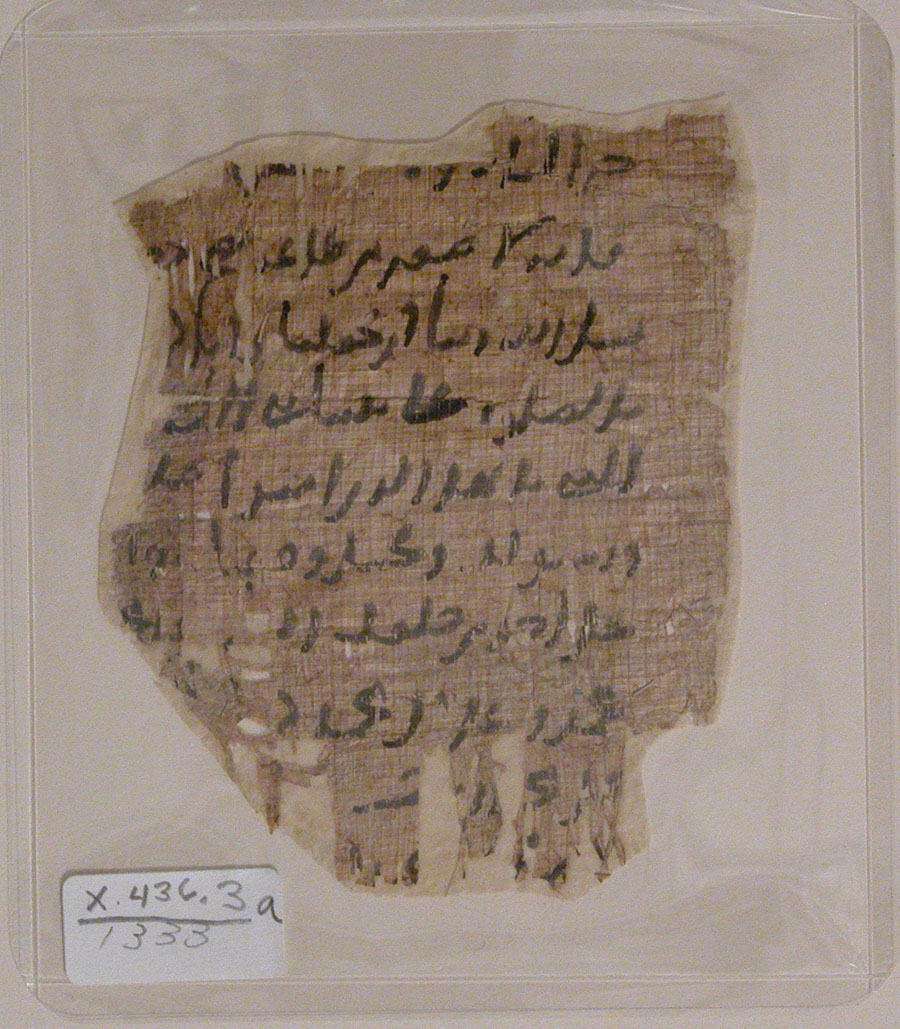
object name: fragment of a non illustrated single work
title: Papyrus Fragment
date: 701-1000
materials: ink, papyrus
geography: egypt